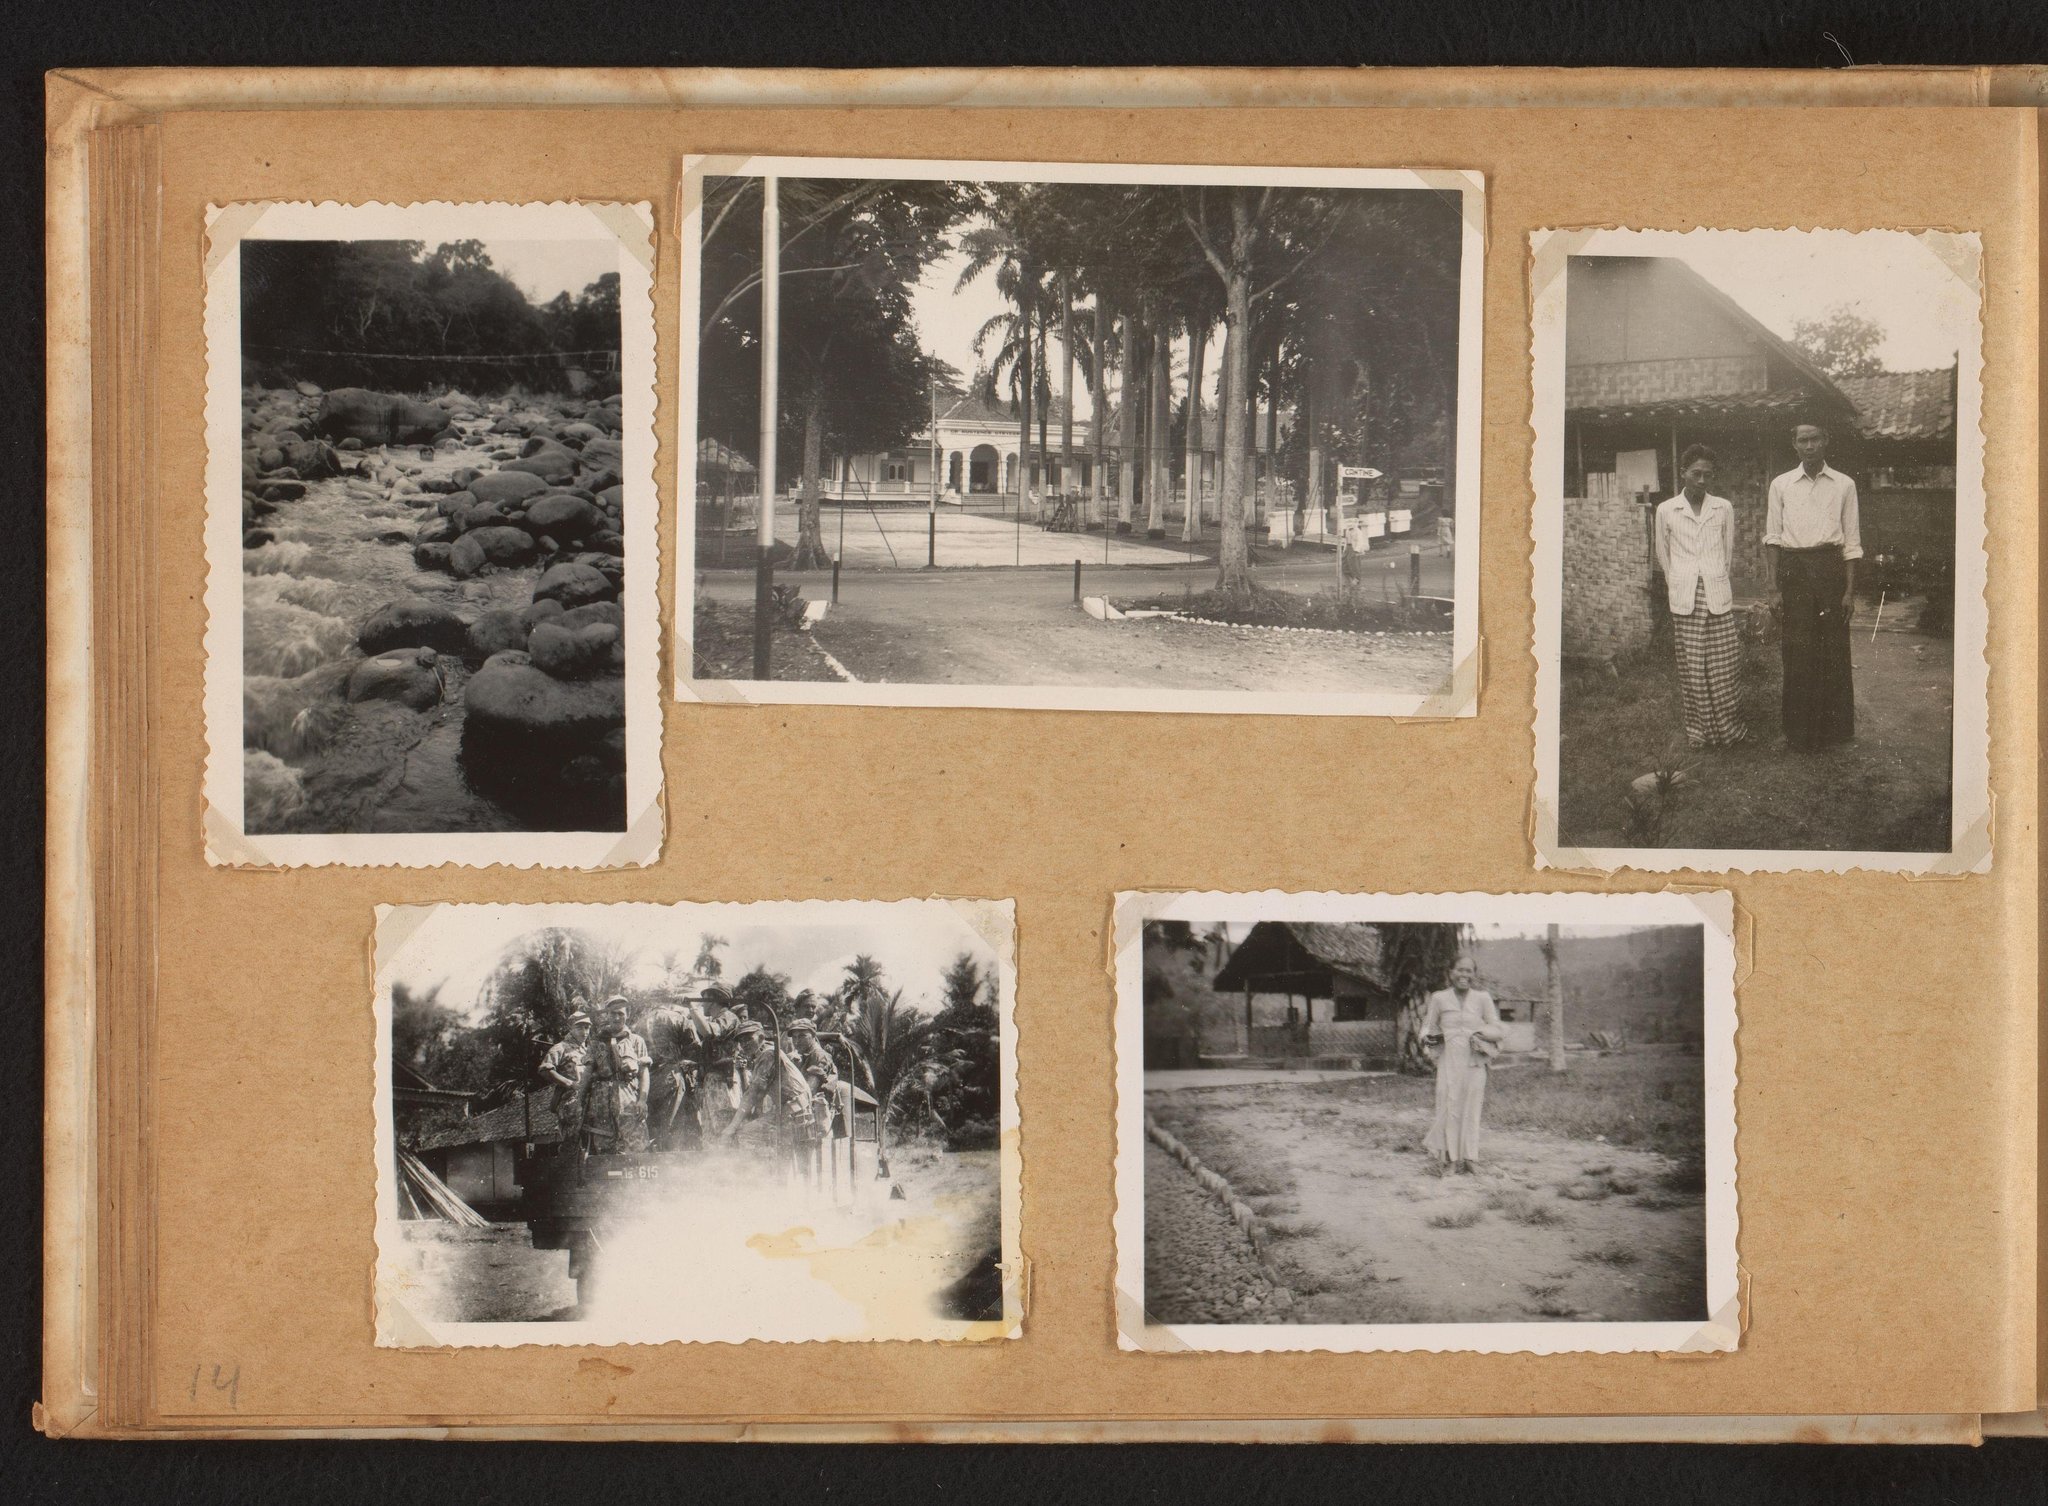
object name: photograph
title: Verlofcentrum en lokale bevolking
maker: Anonymous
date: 1948-1949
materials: paper, photographic support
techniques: gelatin silver print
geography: dutch east indies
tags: the company, the unit, the troop ~ military service, modern forms of military vehicles, recreation ~ the soldier off duty, transport, train (military), dutch east indies, the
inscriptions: inscription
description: Albumblad met vijf foto's van een transport van Nederlandse militairen in een vrachtwagen, van lokale bevolking en van het Militair Verlofcentrum 'De Rustende Strijder' in Bandoeng. Onderdeel van het fotoalbum 'Ter herinnering aan mijn diensttijd overzee' 1948-1949.